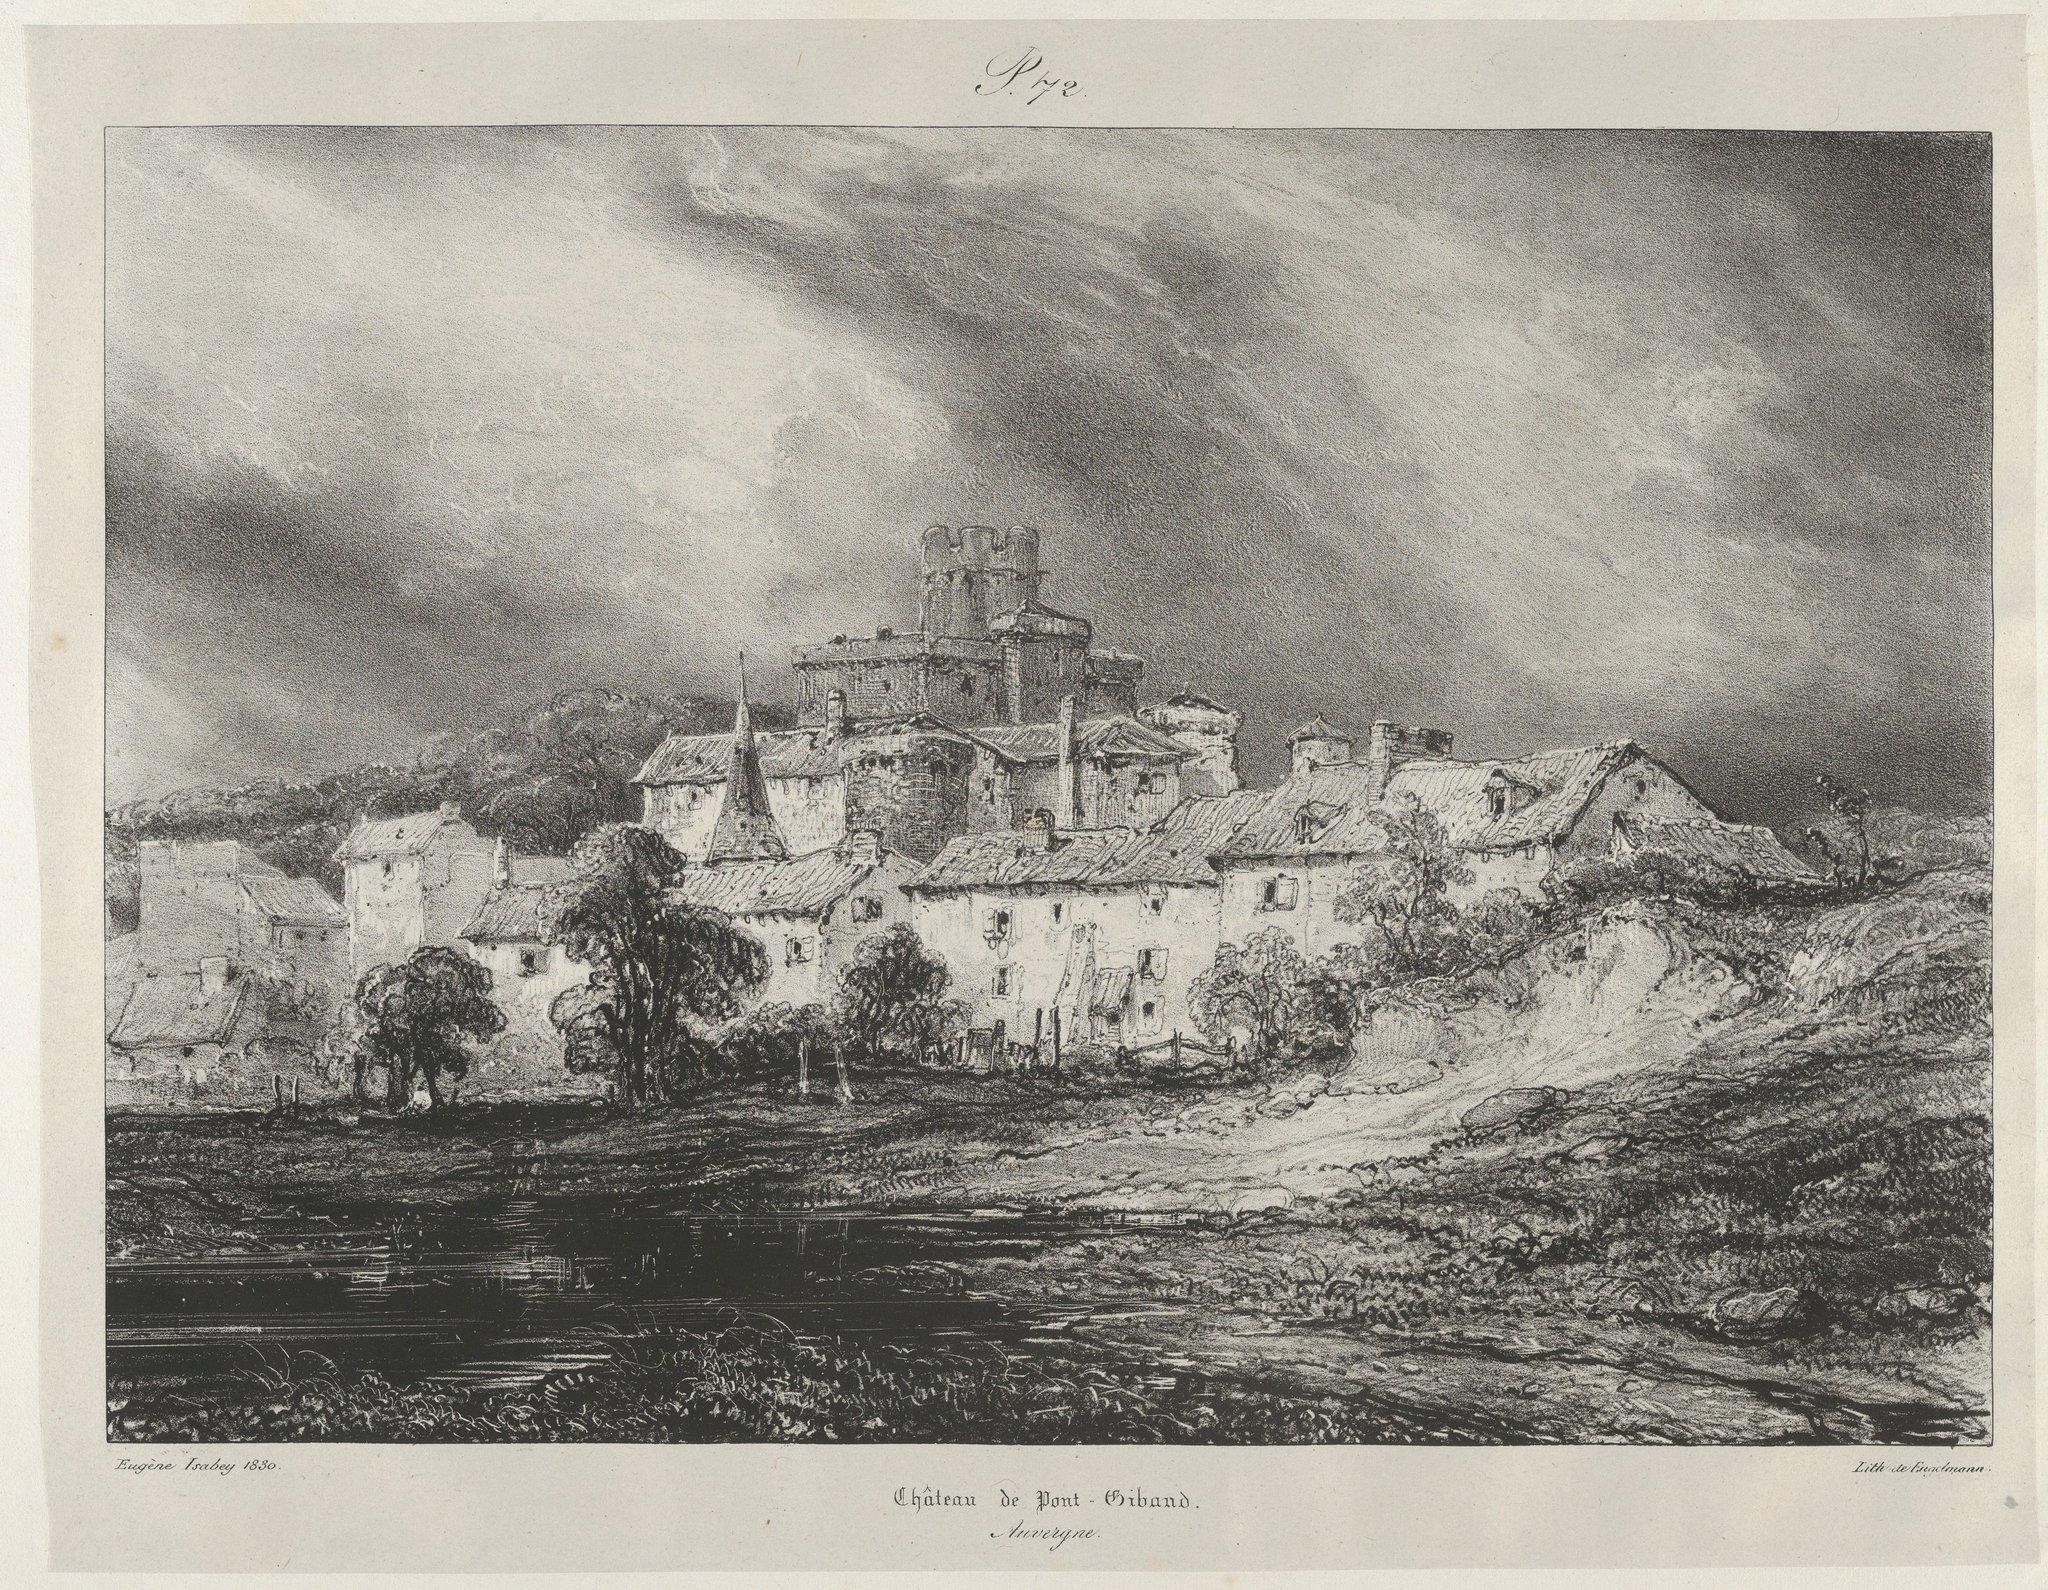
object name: print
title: Pont-Gibaud Castle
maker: eugène isabey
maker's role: artist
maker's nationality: french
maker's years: 1803-1886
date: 1830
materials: paper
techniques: printmaking, lithograph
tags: castles